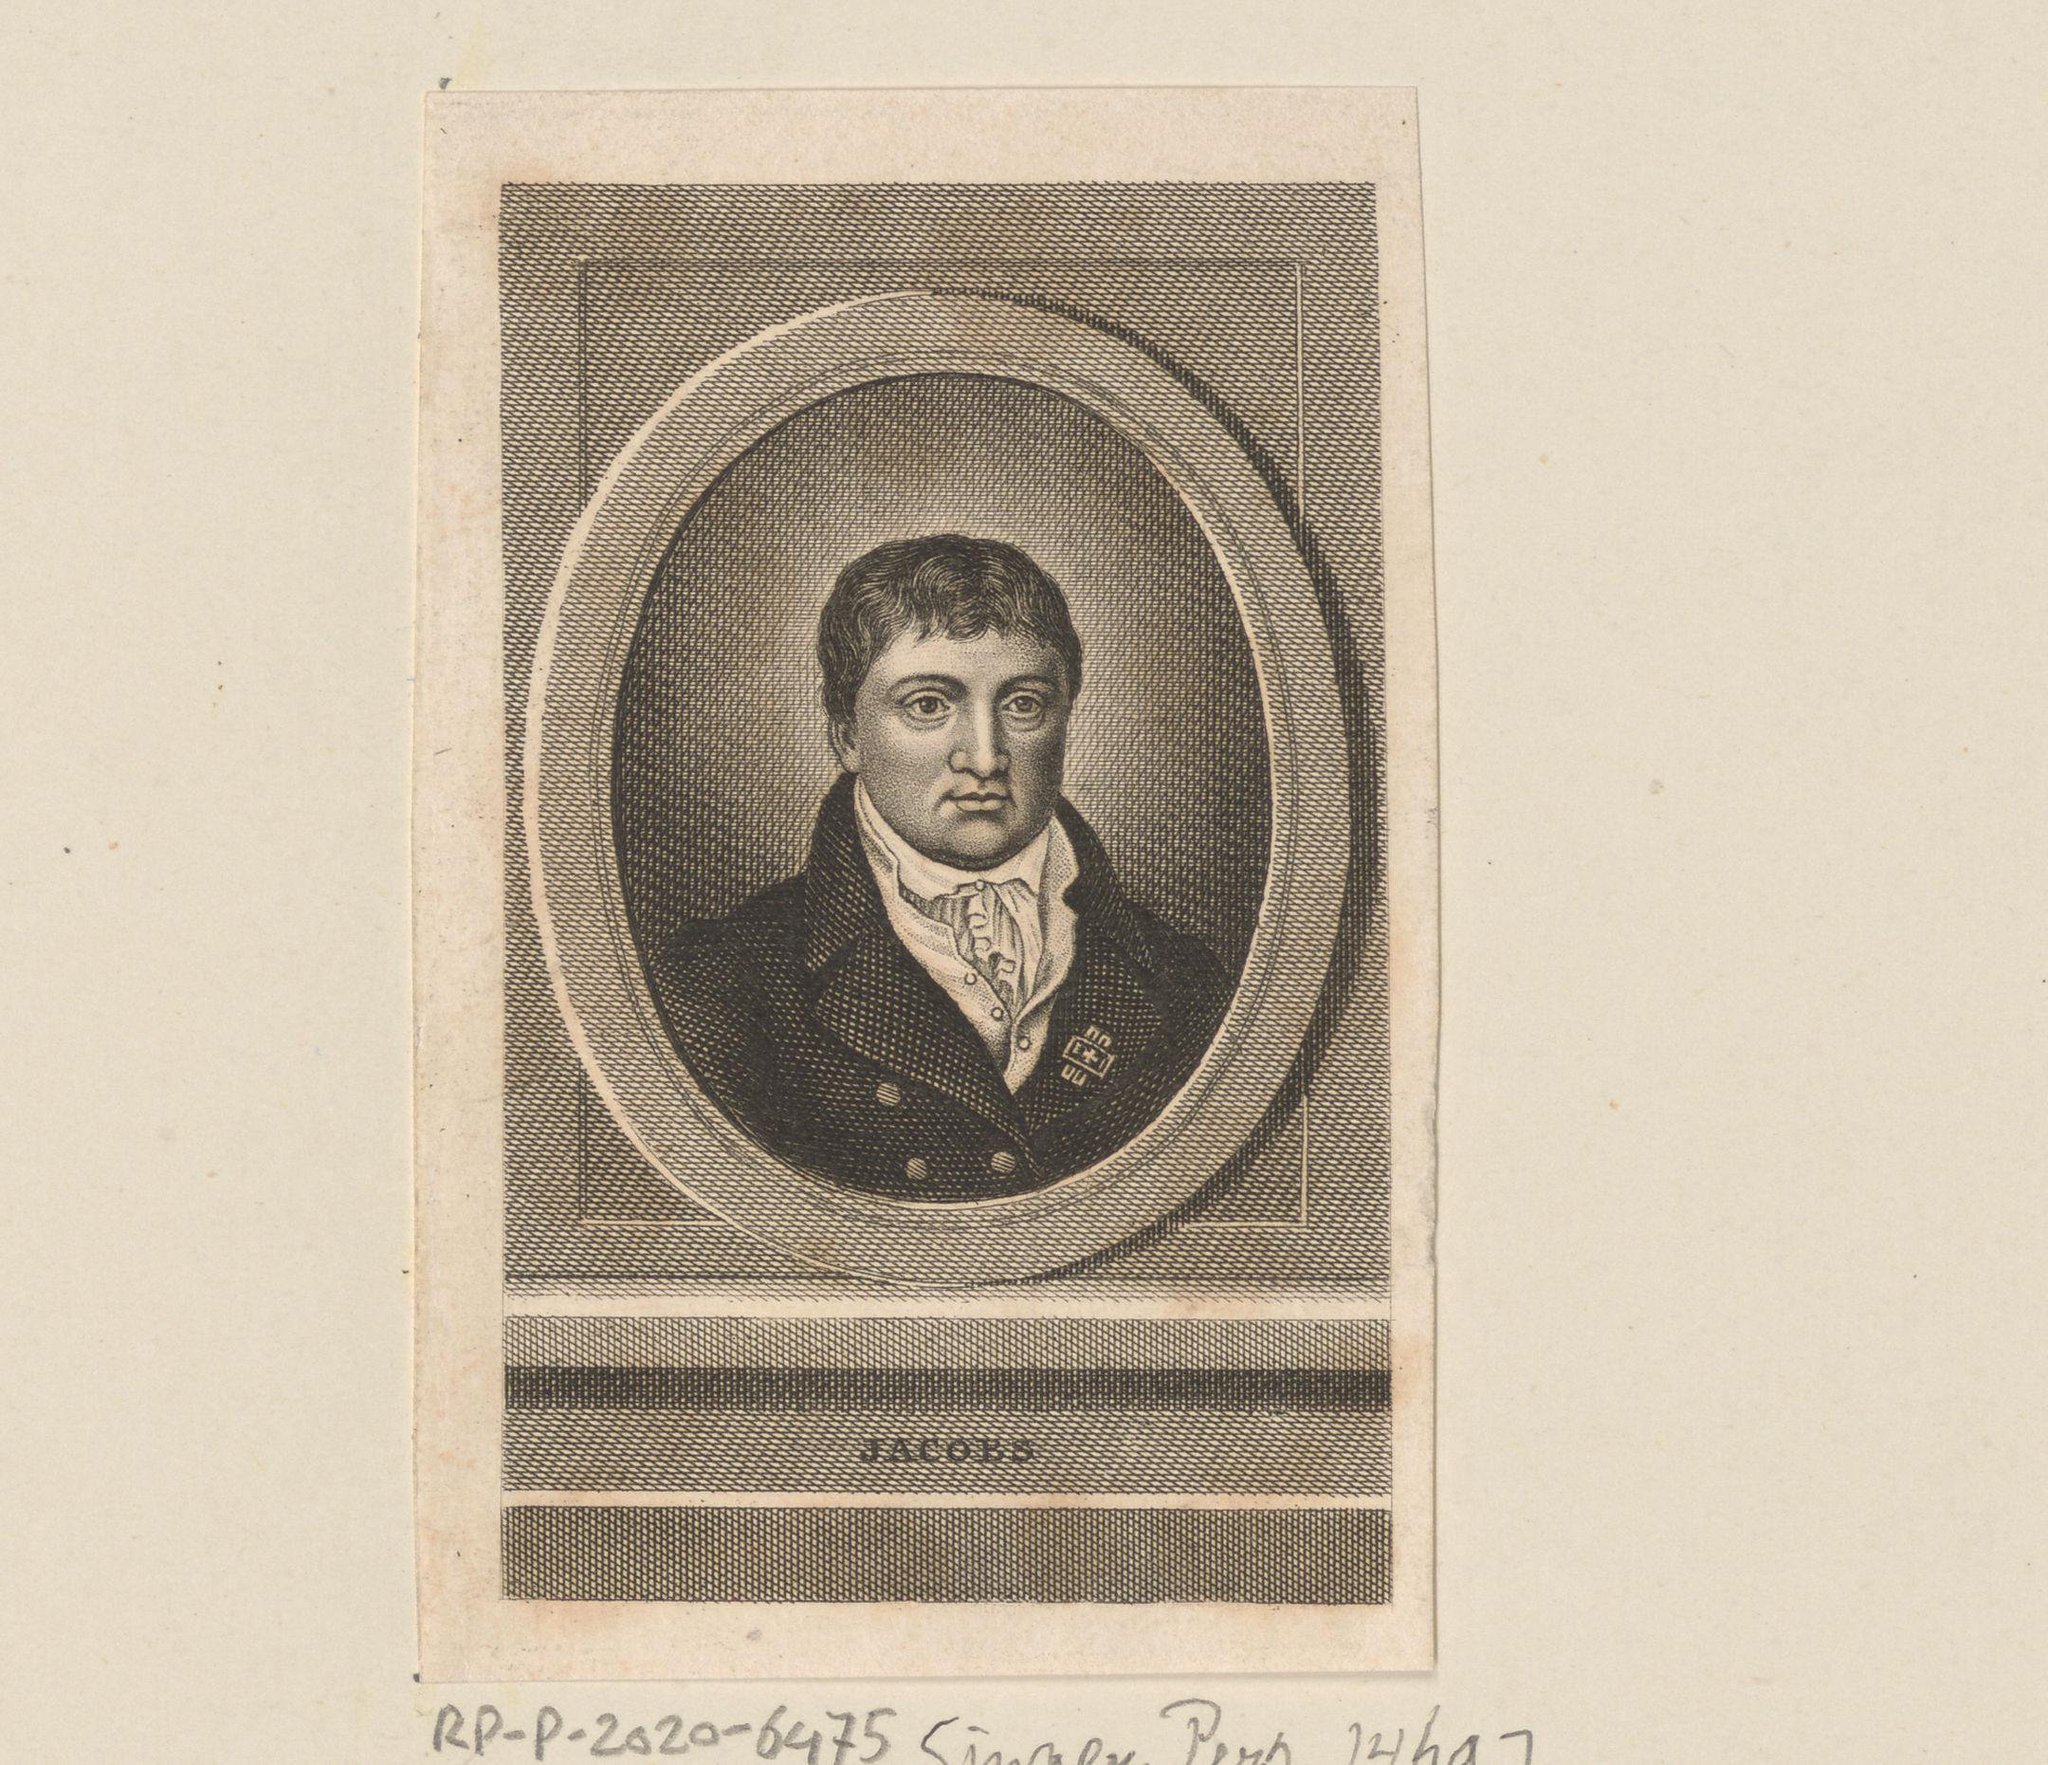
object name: print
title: Portret van Christian Friedrich Wilhelm Jacobs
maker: Anonymous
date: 1785-1850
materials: paper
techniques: etching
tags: theologian, scholar, philosopher, historical persons